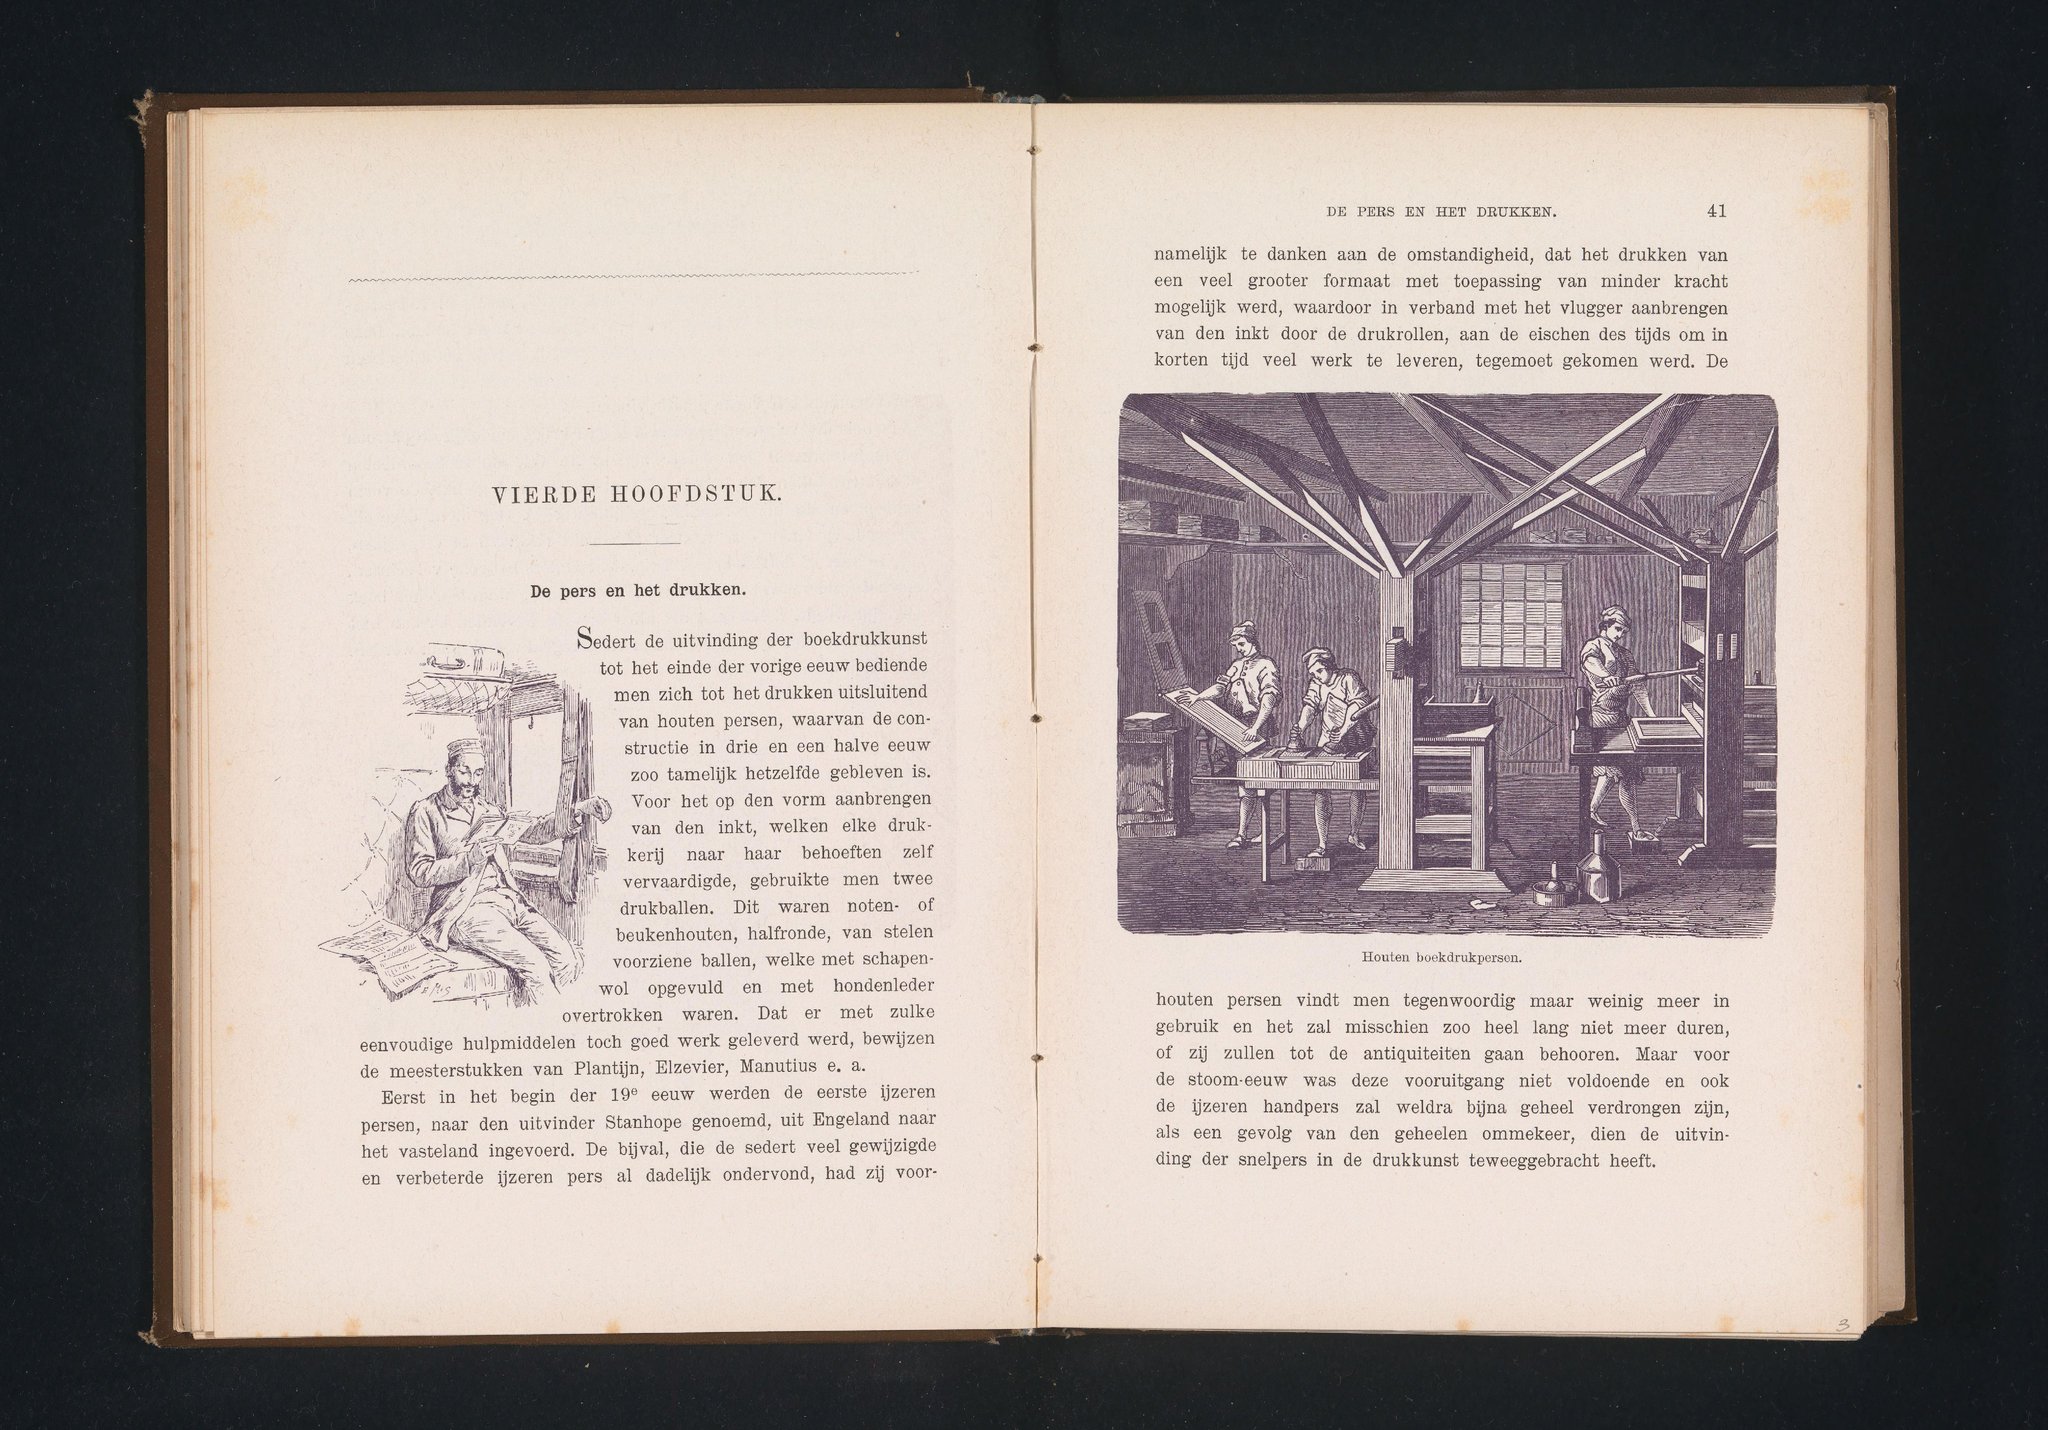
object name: photomechanical print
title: Houten boekdrukpersen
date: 1887-1892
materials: paper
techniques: printing block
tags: adult man, printing press, printing, printing office